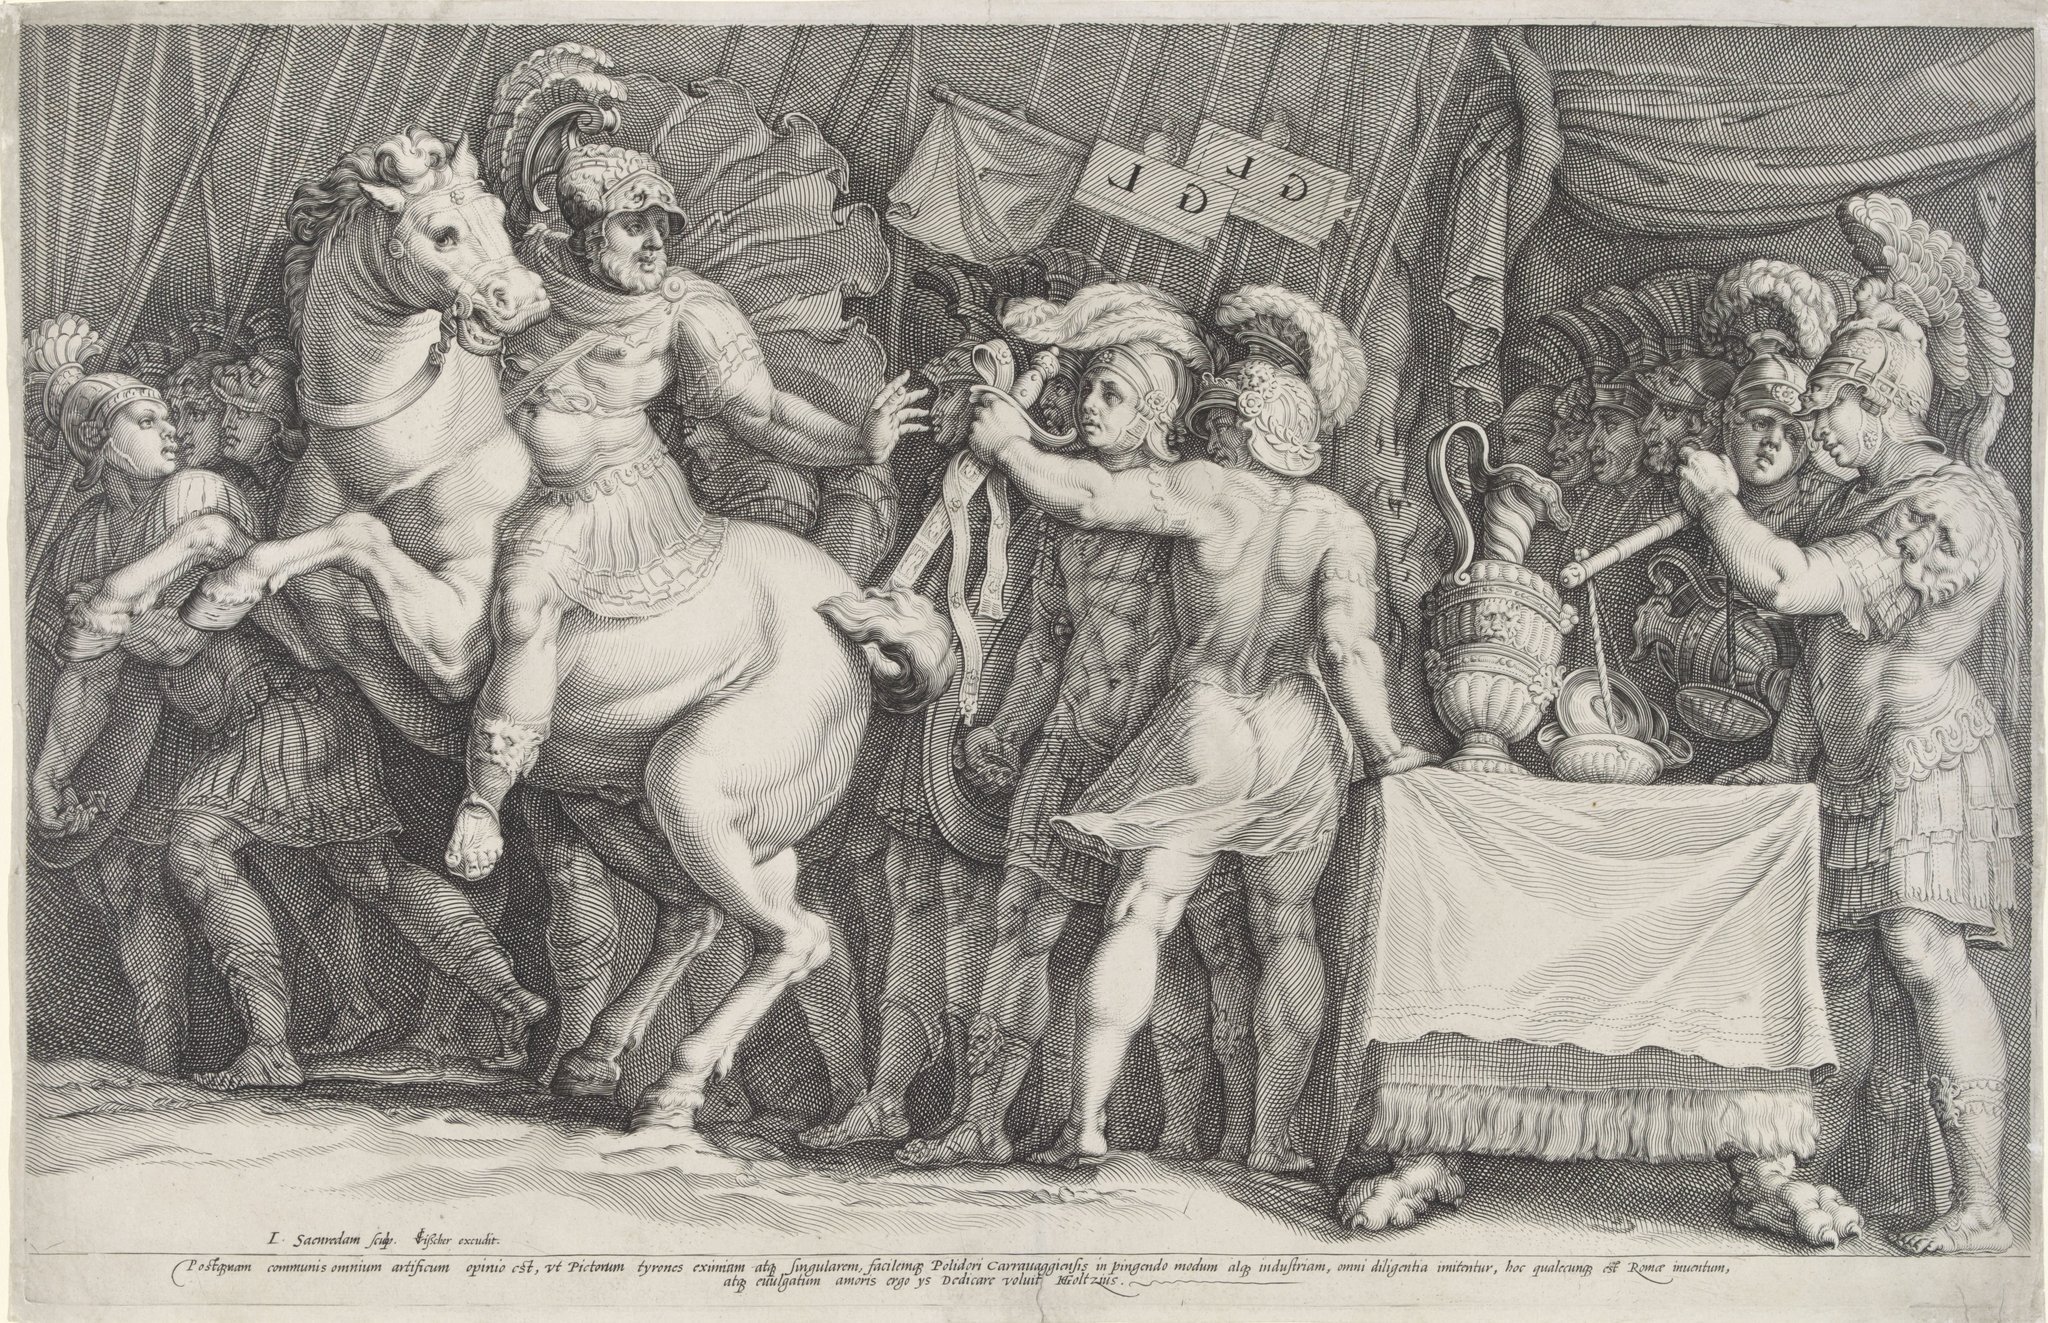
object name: print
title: Marcus Furius Camillus arriveert in Rome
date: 1593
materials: paper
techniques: engraving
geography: italy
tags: riding a horse, ass, or mule; rider, horseman, the soldier; the soldier's life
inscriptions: collector's mark: Lugt 2228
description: Marcus Furius Camillus komt aan in Rome om met de Galliërs te onderhandelen. Hij zit op een paard en reikt naar een zwaard dat hem door een soldaat wordt aangereikt. Rechts staat een groep gewapende soldaten achter een tafel, van wie één waardevolle spullen weegt. Onder de voorstelling een tweeregelige, Latijnse tekst.